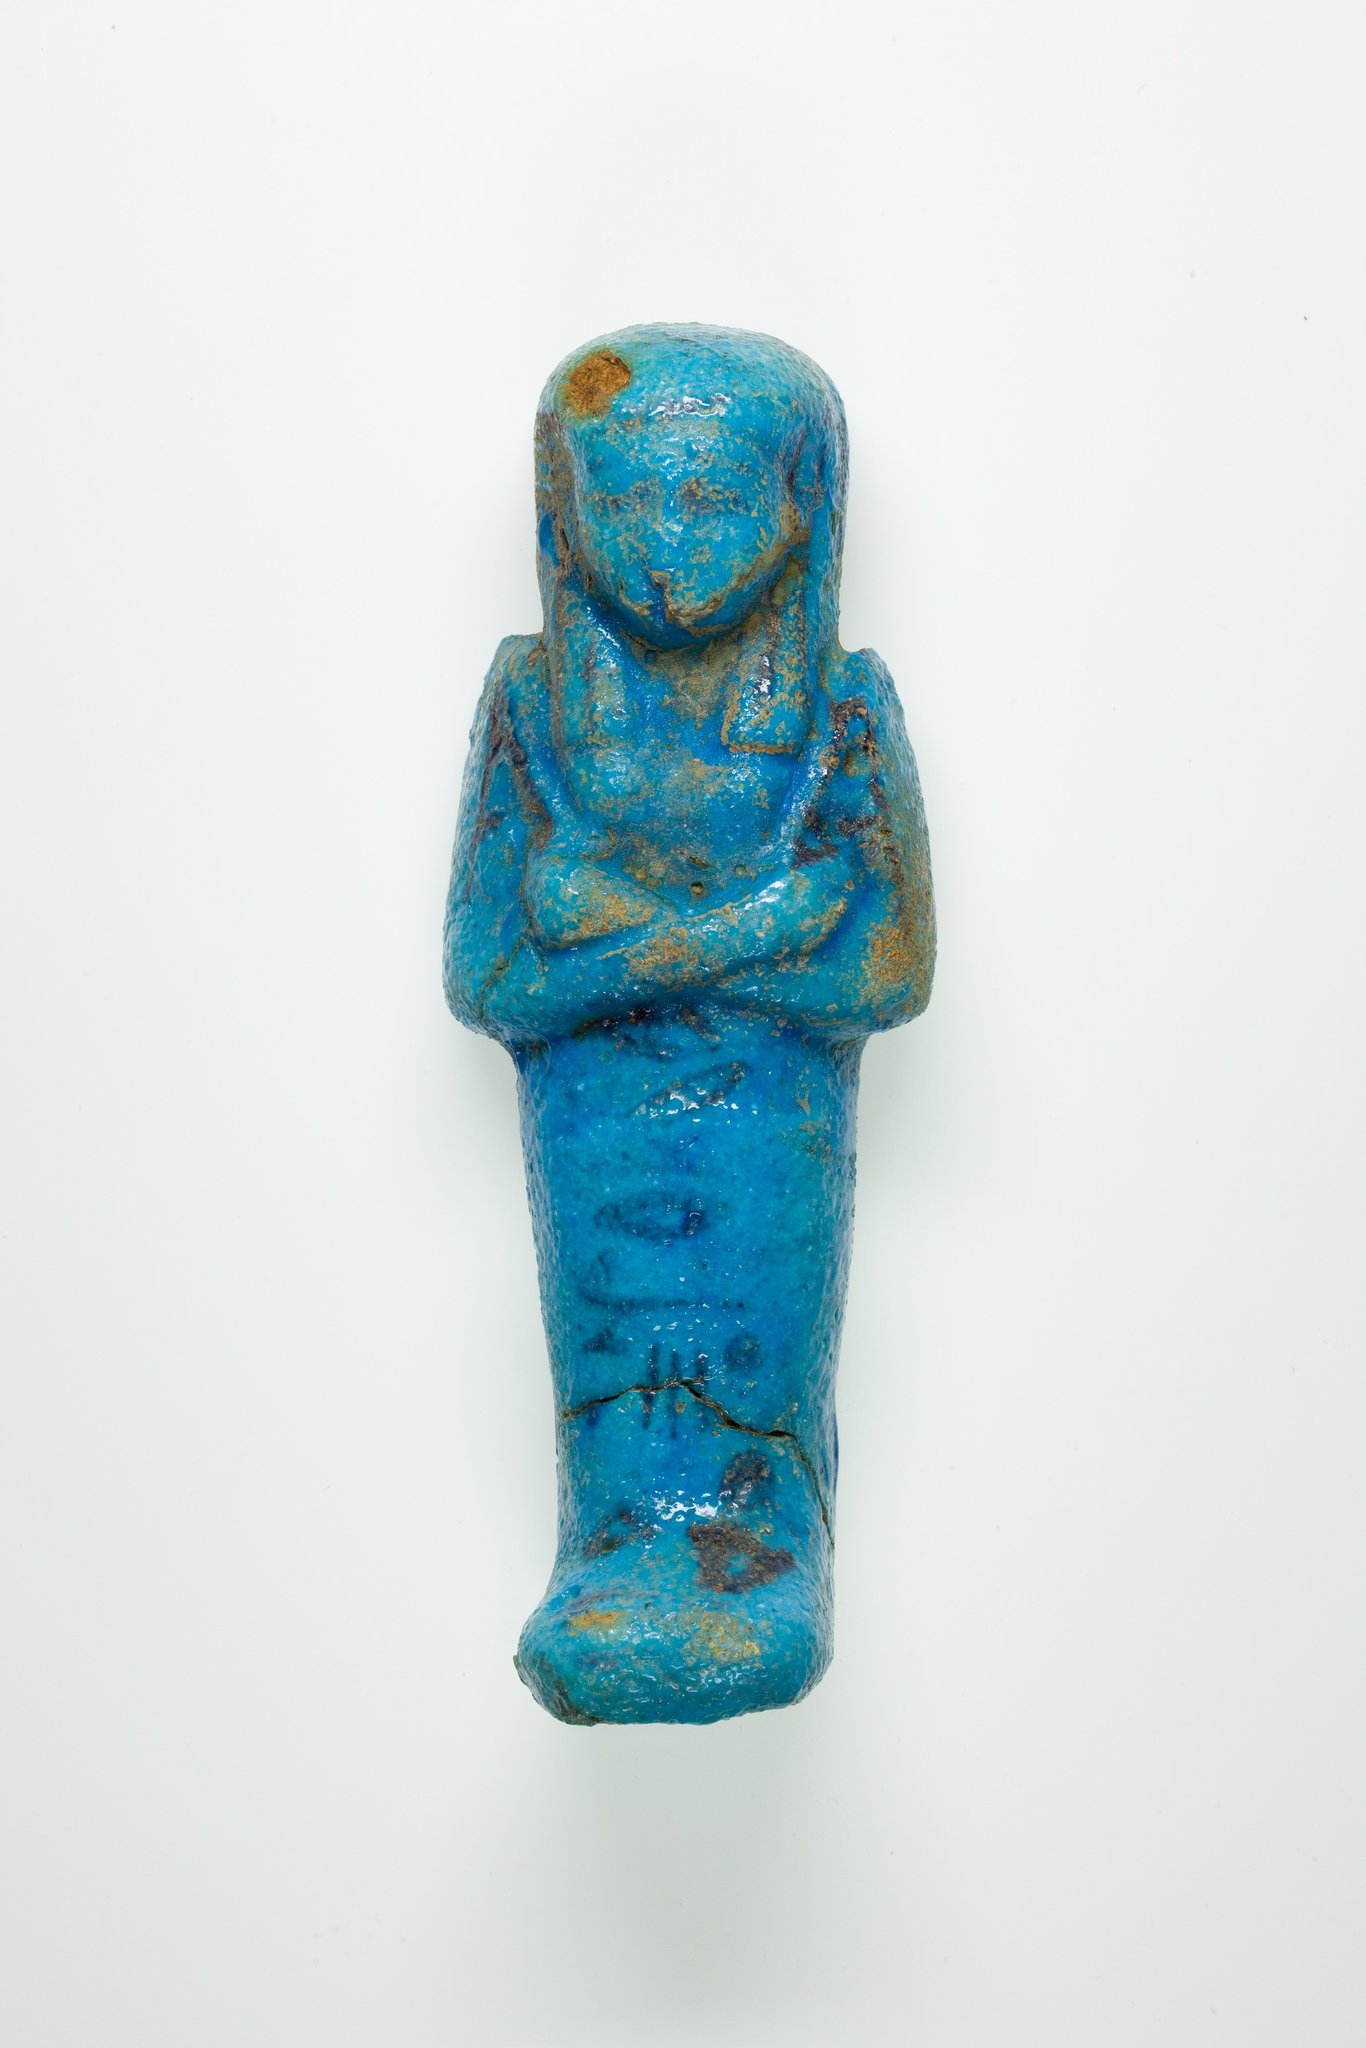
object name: worker shabti, henettawy c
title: Worker Shabti of Henettawy (C), Daughter of Isetemkheb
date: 990-970 BCE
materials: faience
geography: egypt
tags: hieroglyphs